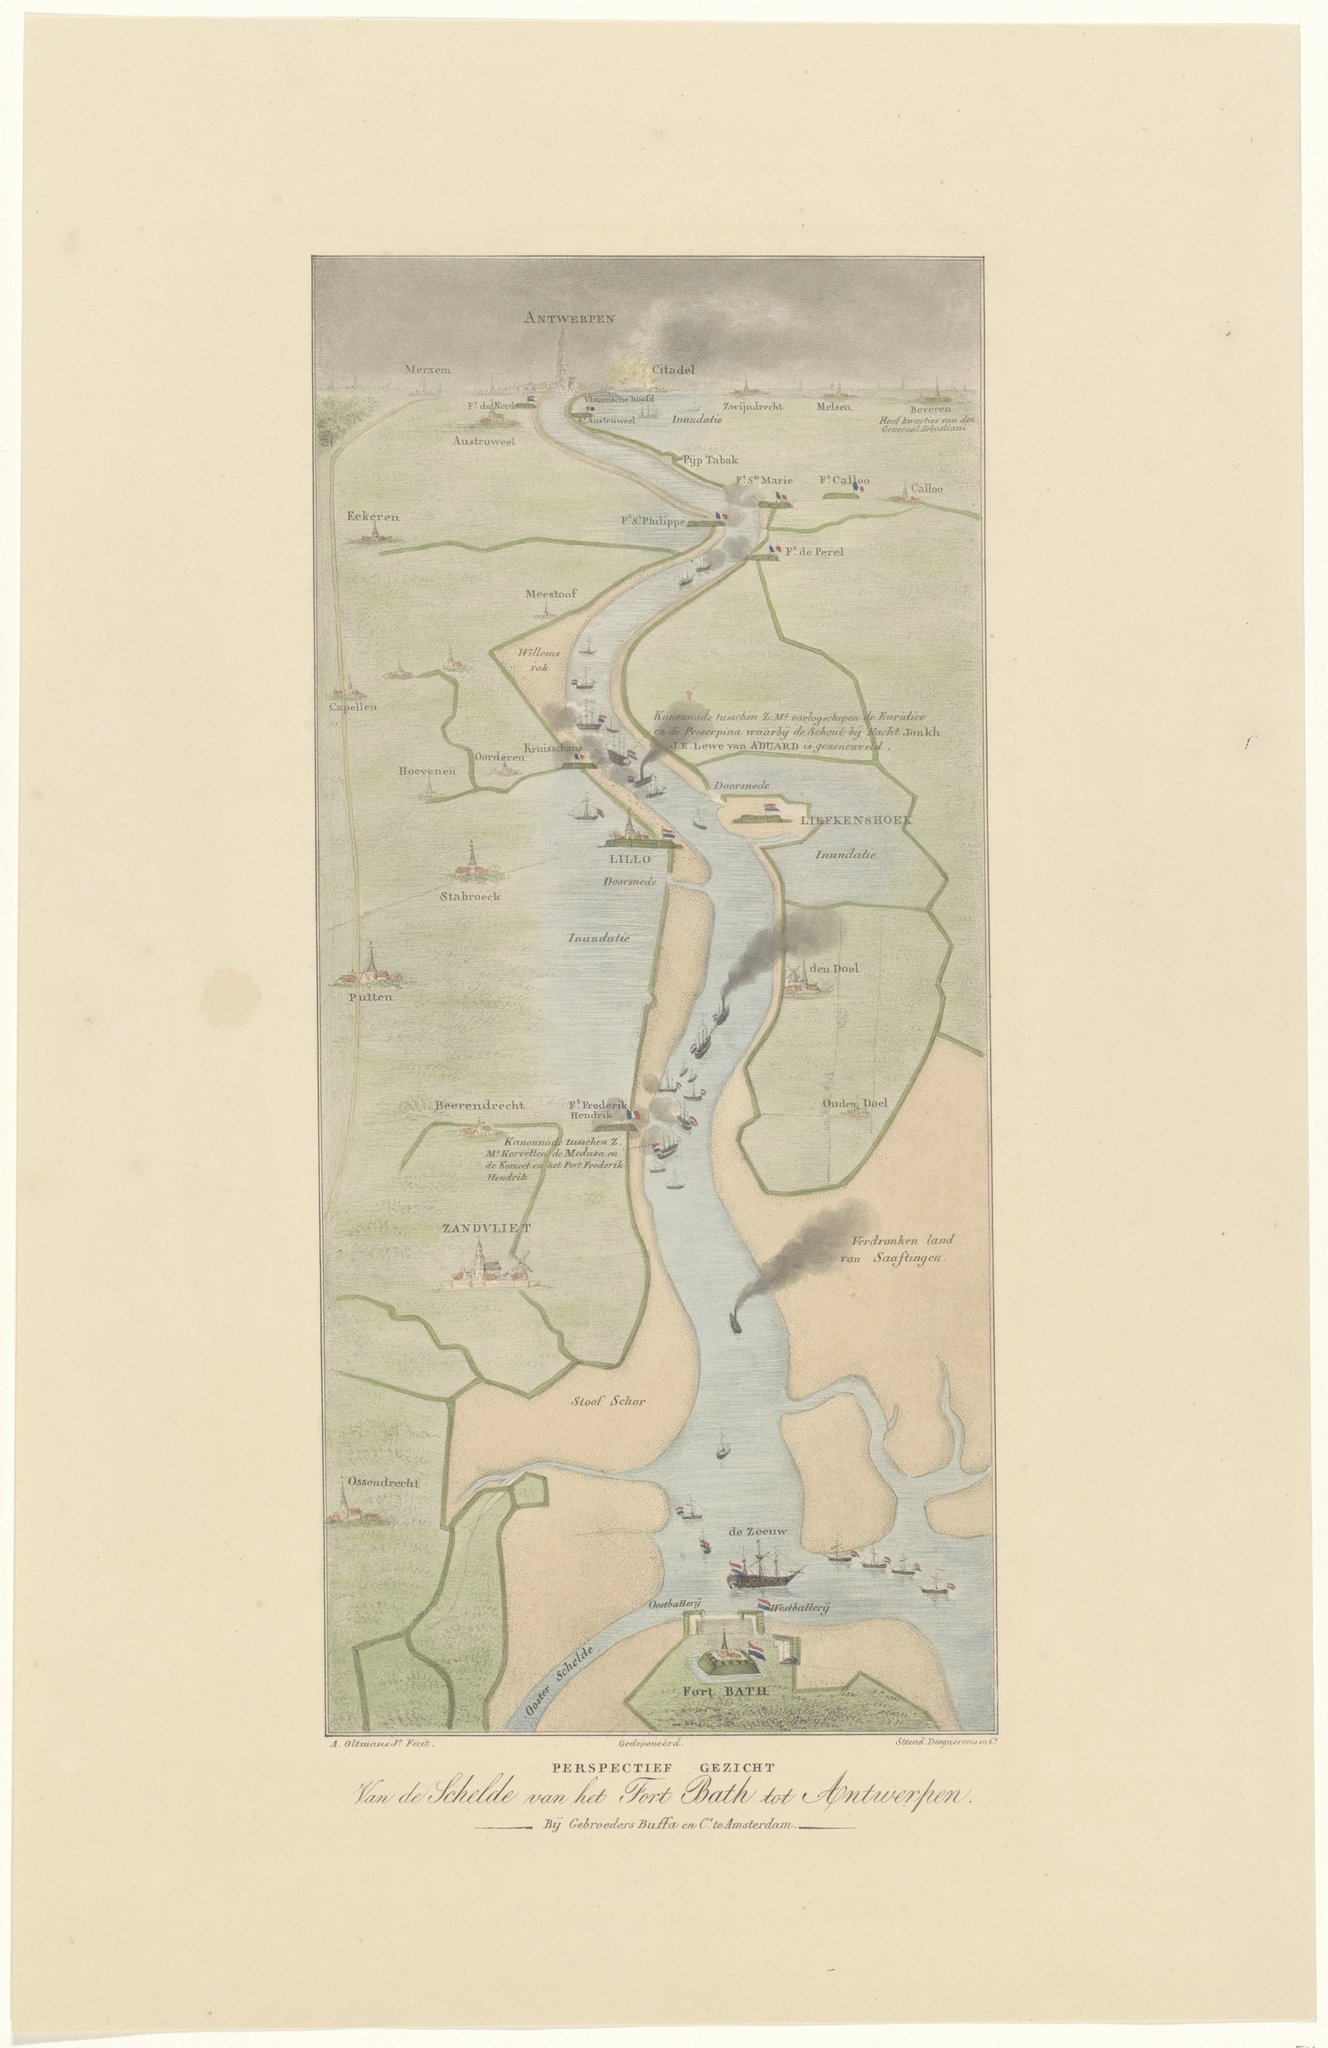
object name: print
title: Perspectief Gezicht Van de Schelde van het Fort Bath tot Antwerpen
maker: alexander oltmans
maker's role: draughtsman, print maker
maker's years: 1814-1853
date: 1832-1833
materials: paper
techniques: hand coloring, lithograph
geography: amsterdam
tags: antwerp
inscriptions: collector's mark: Lugt 2228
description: Gezicht in vogelvlucht van de loop van de Schelde van Fort Bath in Zeeland tot aan de stad Antwerpen, ten tijde van het beleg van Antwerpen in december 1832. Op de rivier zijn op verschillende plekken de incidenten weergegeven die daar plaatsvonden, zoals de schermutselingen bij Fort Frederik Hendrik en bij de Kruisschans (12 december) waarbij Jan Evert Lewe van Aduard sneuvelt.